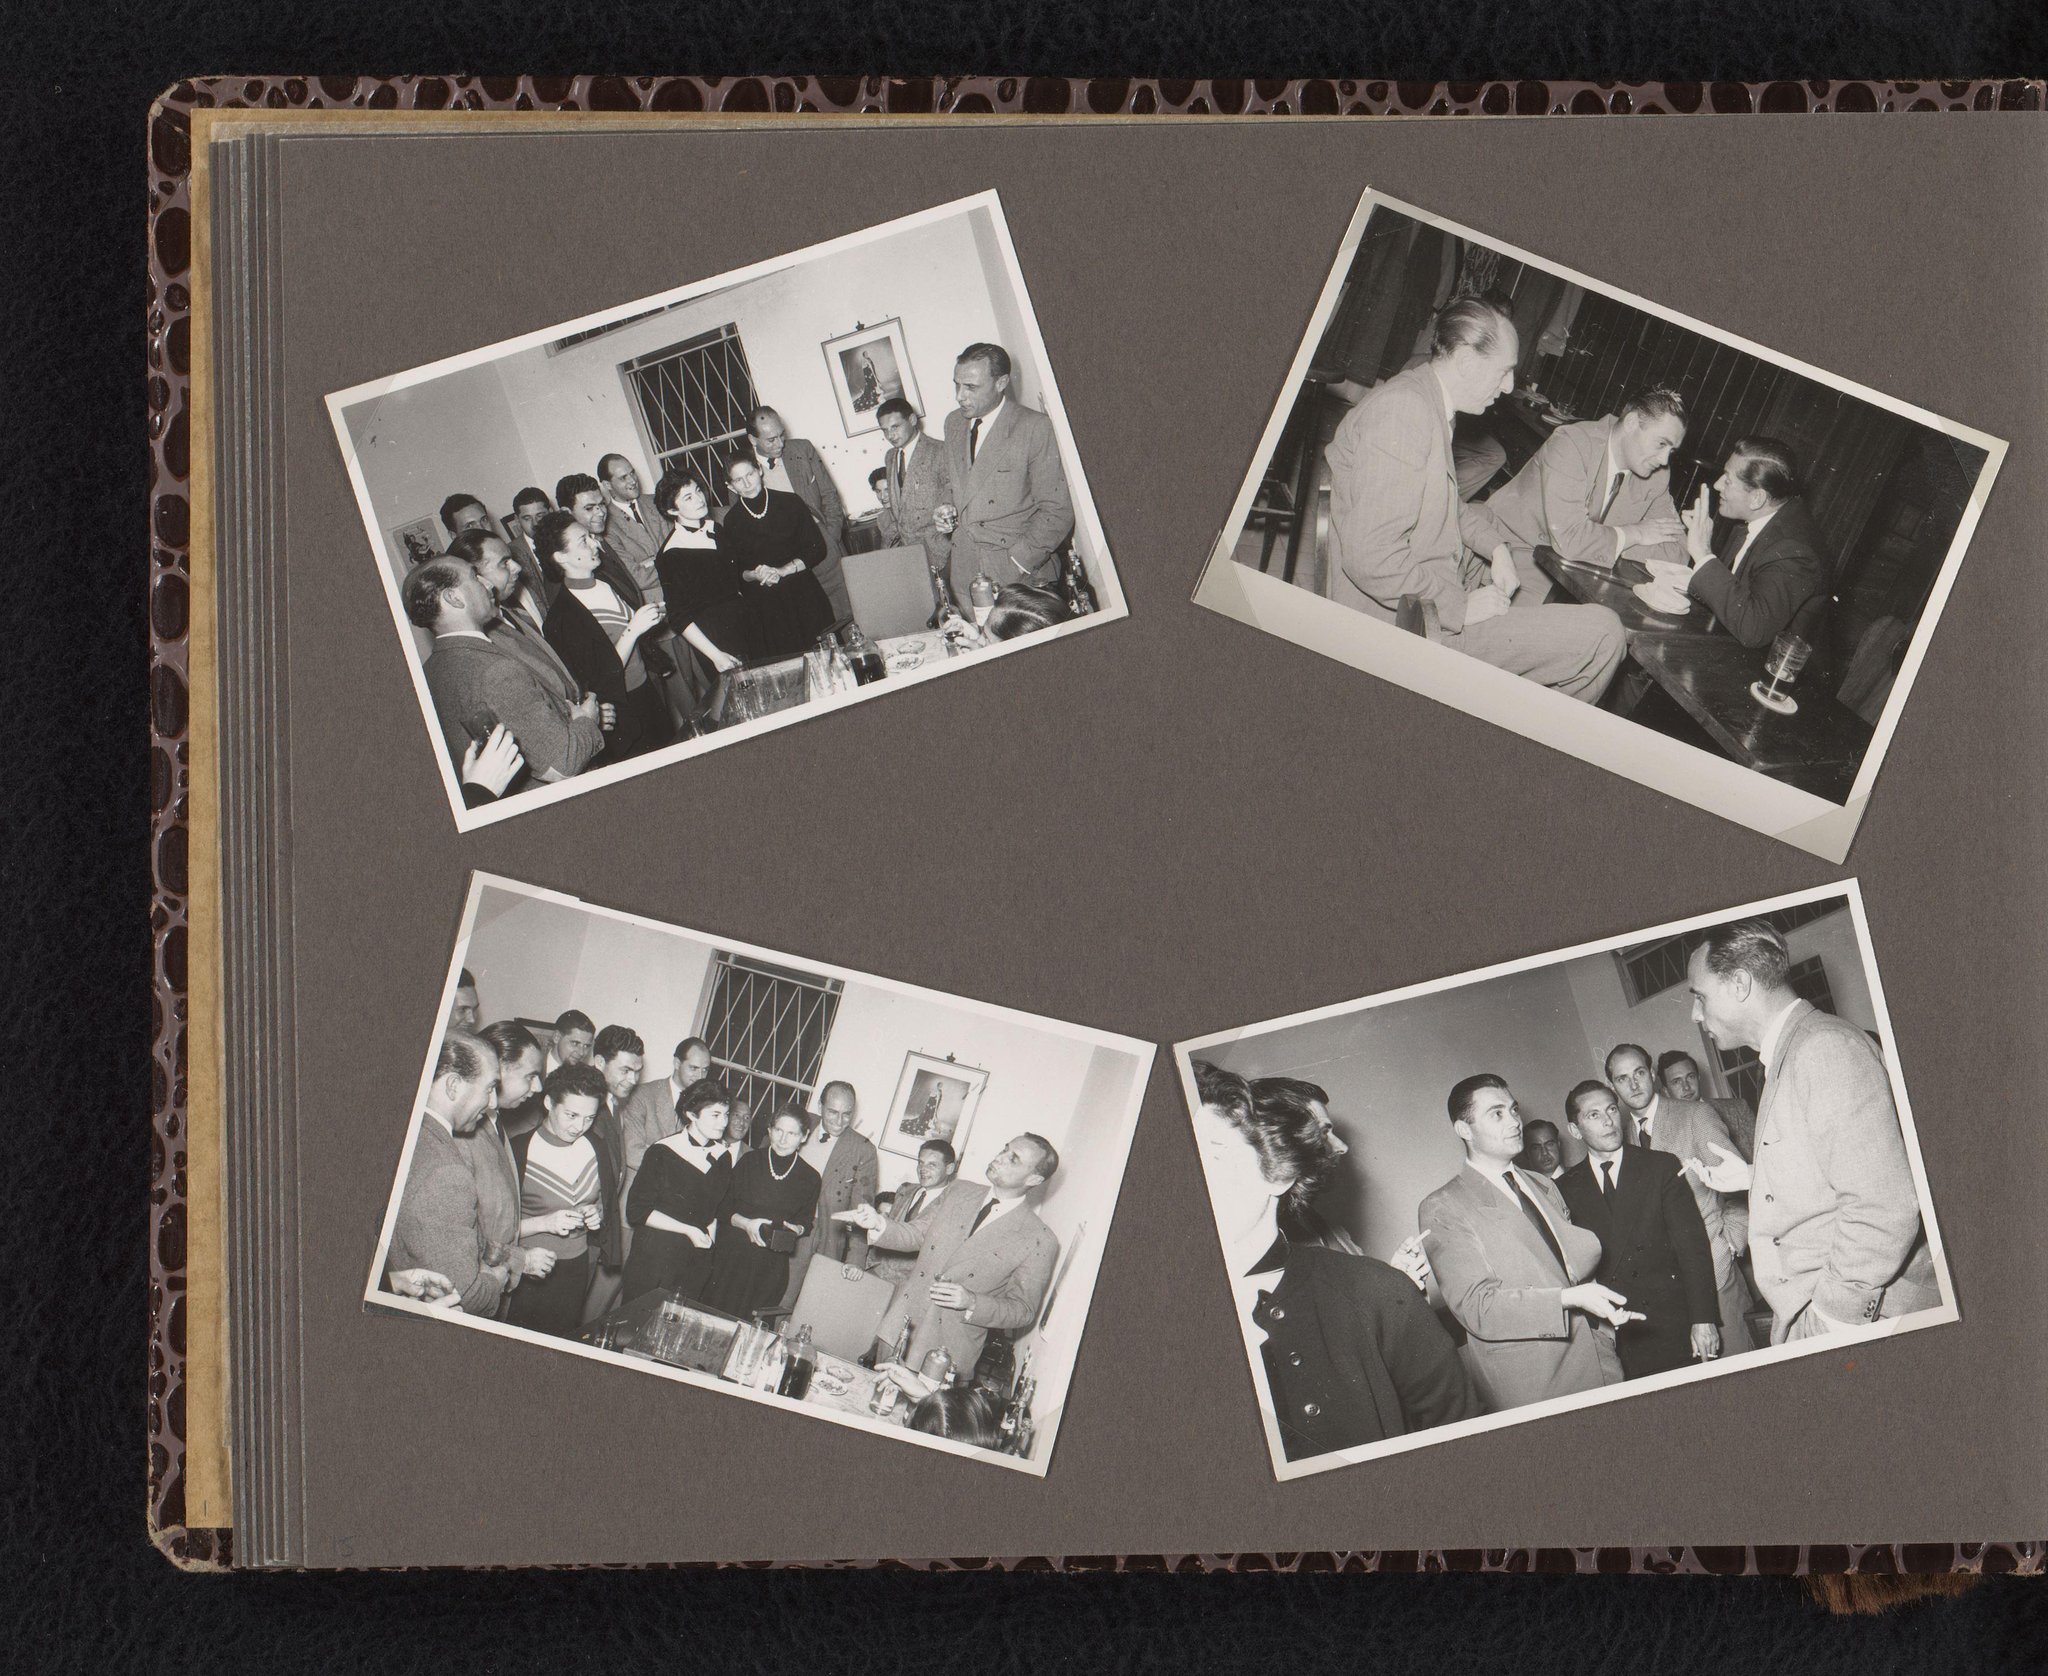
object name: album leaf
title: Isabel Wachenheimer en haar derde echtgenoot Gideon Elon met onbekende collega's van Isabel tijdens haar periode bij KLM, 1955, Israël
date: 1955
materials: cardboard, photographic support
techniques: gelatin silver print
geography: tel aviv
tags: leiden, isabel wachenheimer-elon, gideon elon, anonymous historical persons portrayed in a group, in a group-portrait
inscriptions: inscription: ‘Abschied Koreman / Tel-Aviv 1 Febr. 1955’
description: Blad bevat vier foto's van Isabel Wachenheimer, Gideon Elon en onbekende collega's, bij afscheid van een collega, februari 1955. Uit album half formaat, kunstlederen omslag met koordbinding.